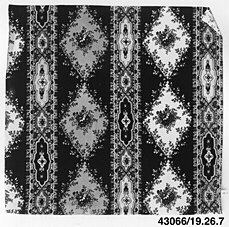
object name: sample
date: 1840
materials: cotton